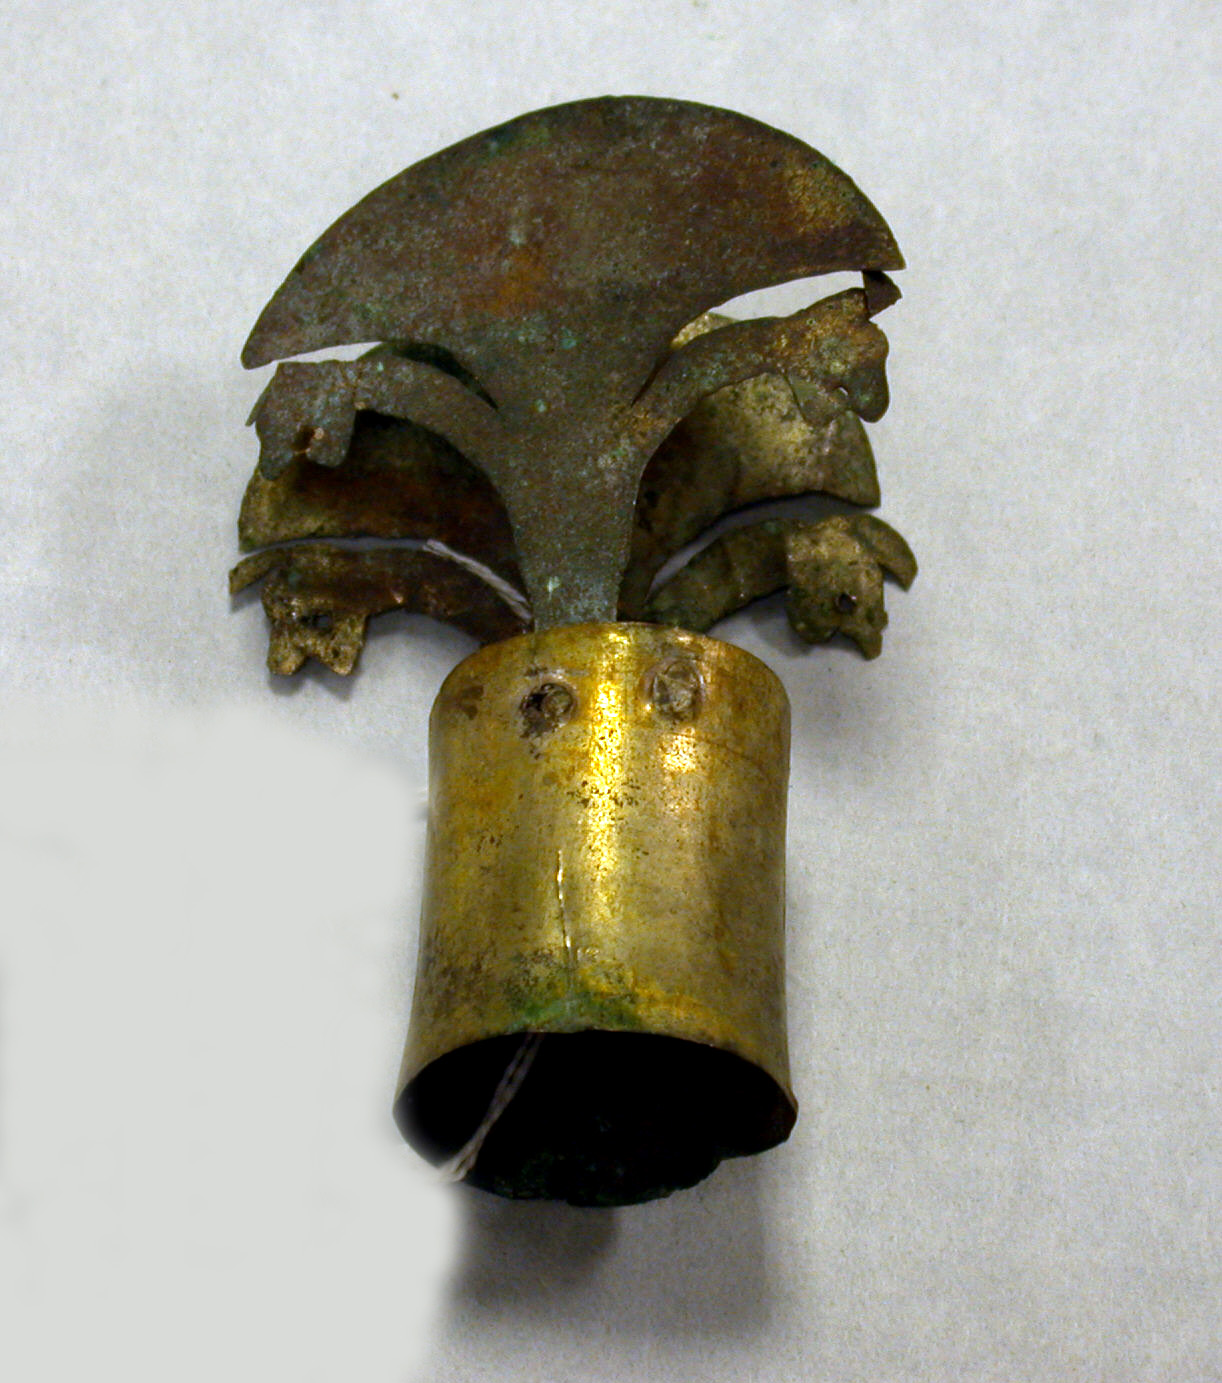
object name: crown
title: Hammered Silver Miniature Crown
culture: peruvian, north or central coast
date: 1001-1566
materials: gilt, silver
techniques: hammering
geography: peru